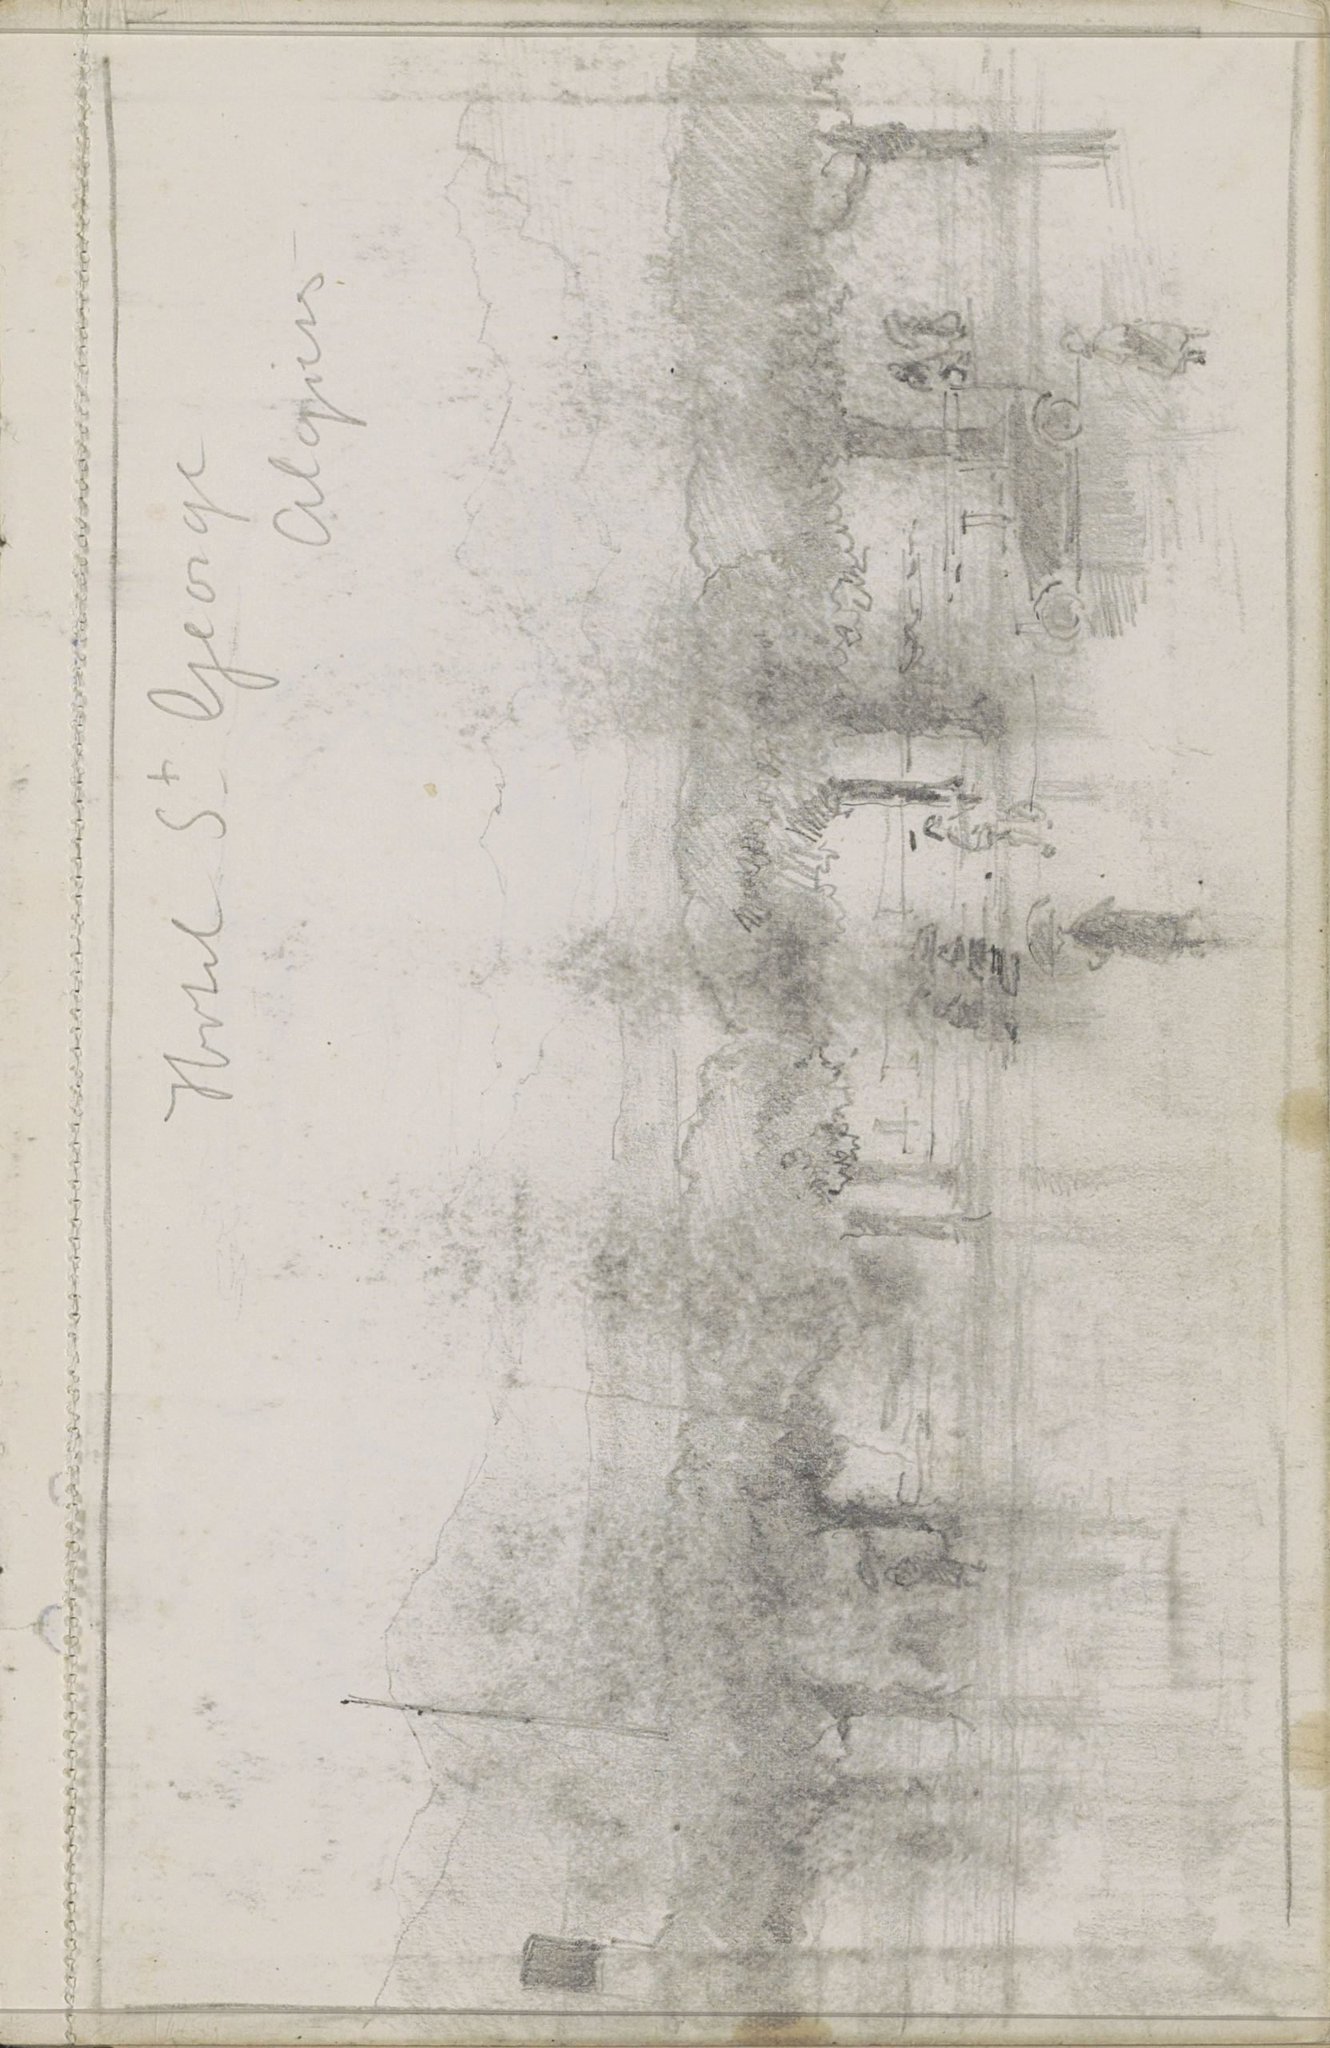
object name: sketchbook leaf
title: Landschap met figuren bij een bomenlaan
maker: cornelis vreedenburgh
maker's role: draughtsman, print maker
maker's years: 1880-1946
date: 1890-1946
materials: paper, pencil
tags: trees, mountains (+ landscape with figures, staffage)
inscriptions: annotation: ‘Hotel St George/ Algiers’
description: Enkele figuren dragen een paraplu. Op de achtergrond bergen. Blad 2 recto uit een schetsboek met 53 bladen.